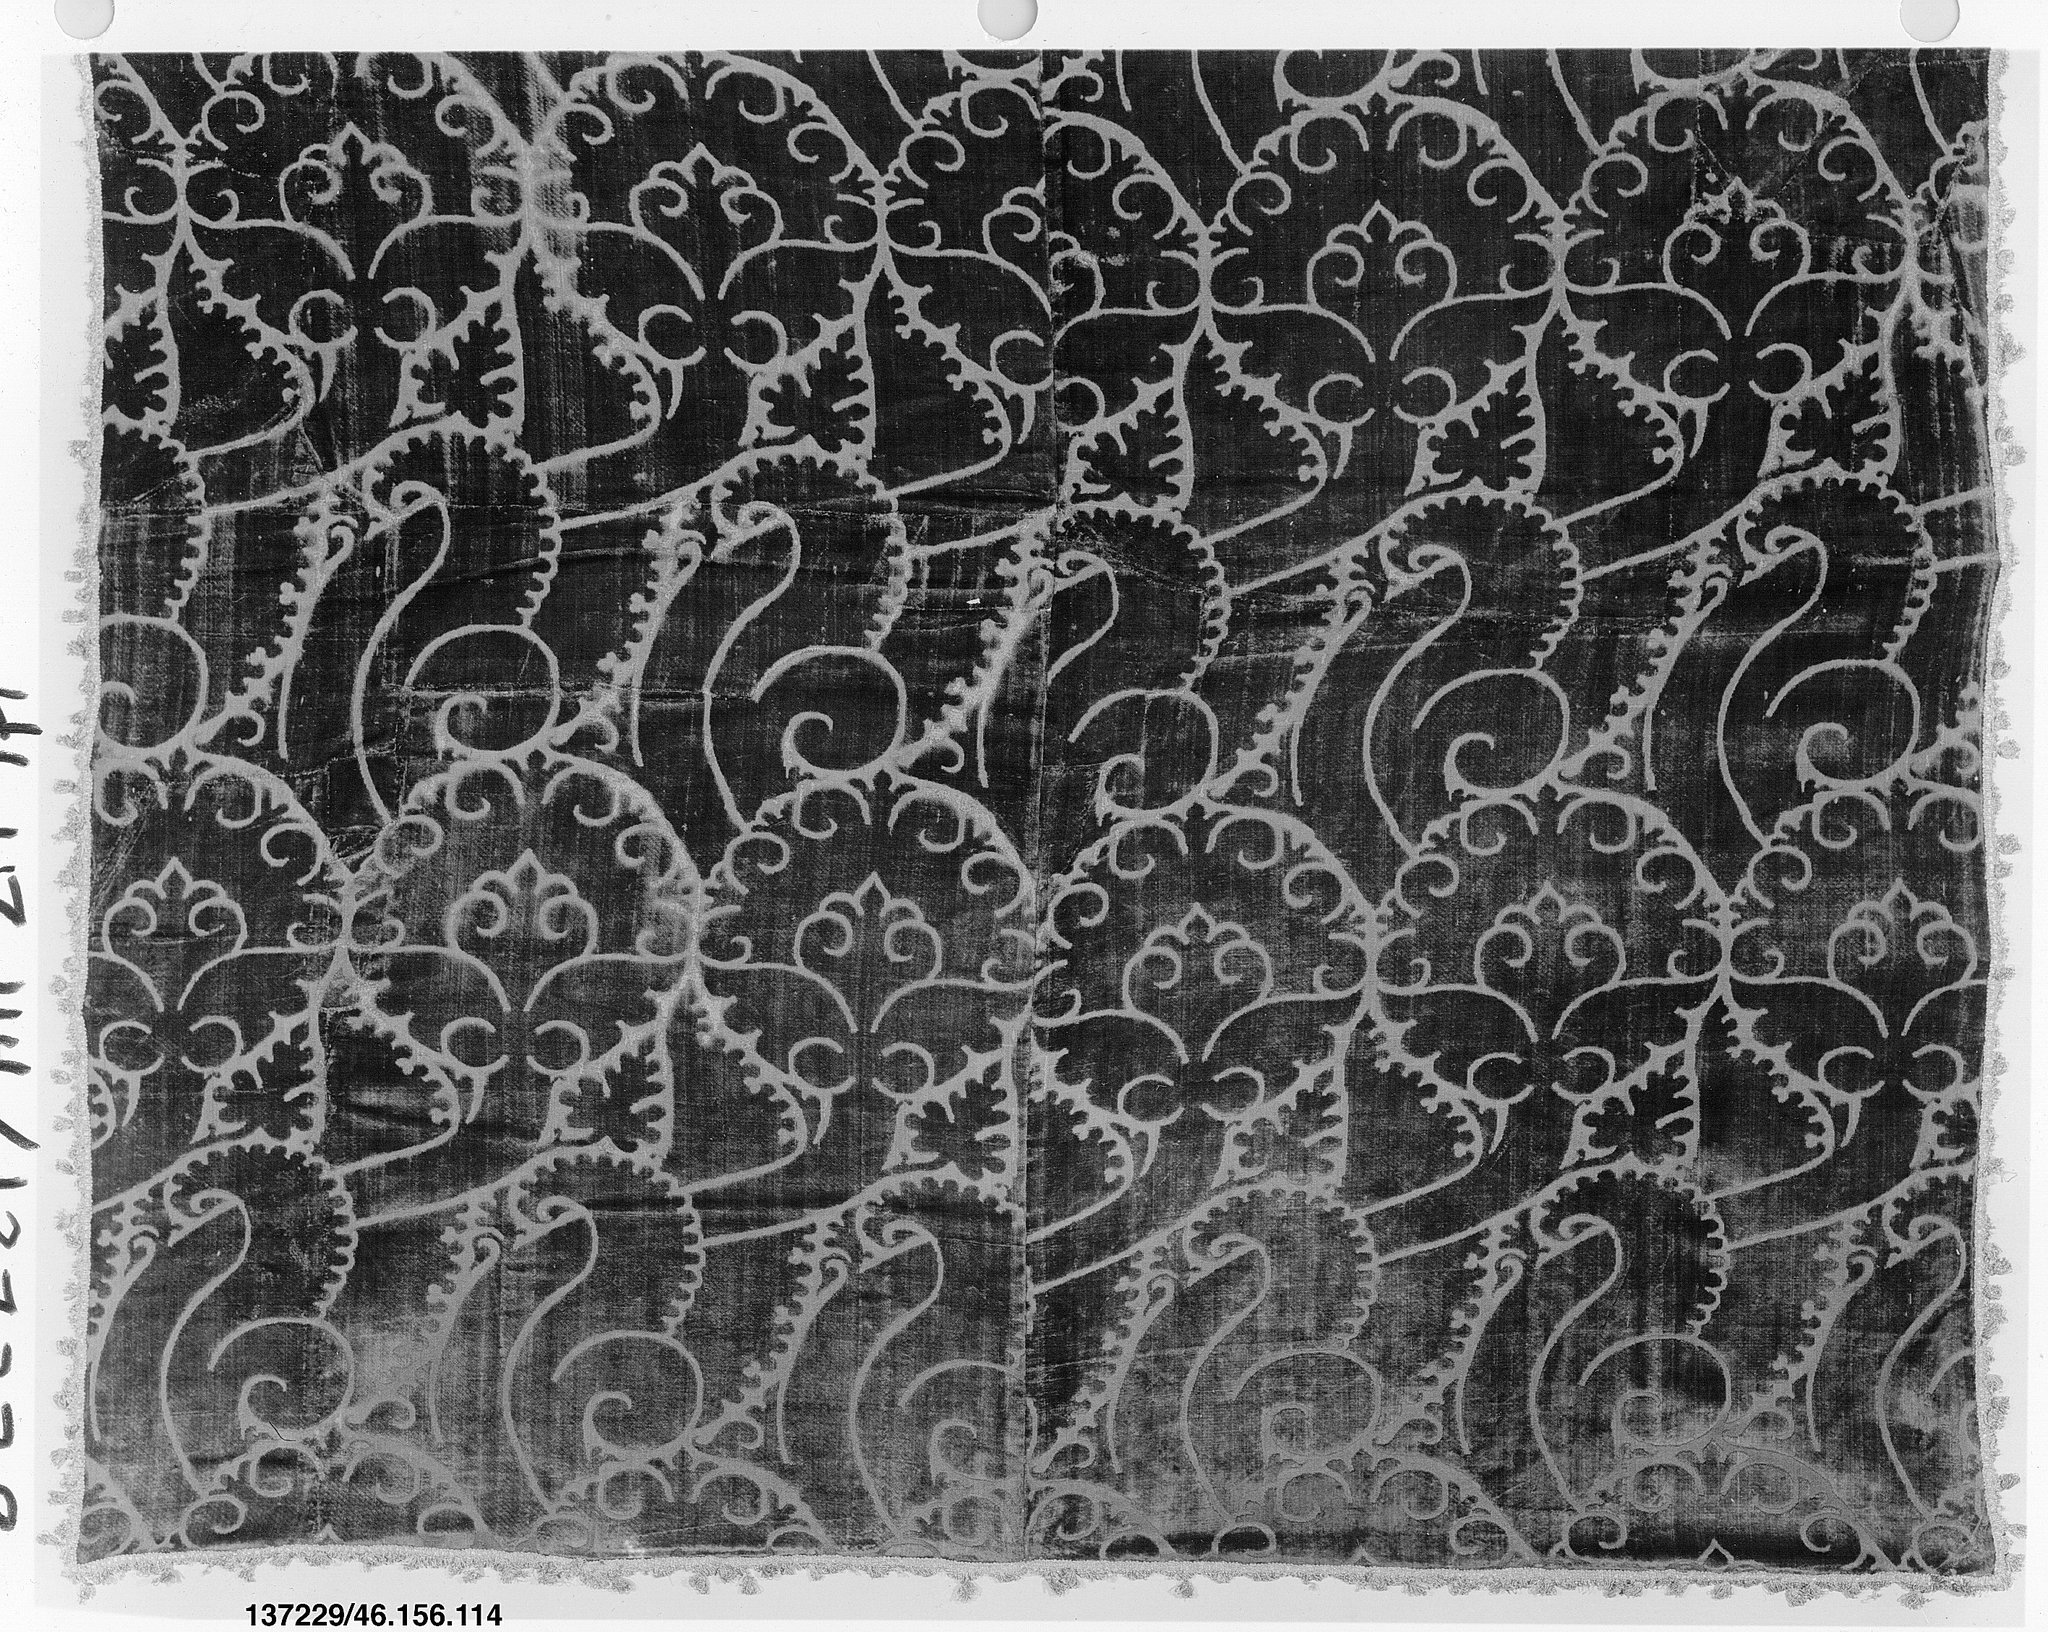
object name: piece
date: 1440-1460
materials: silk